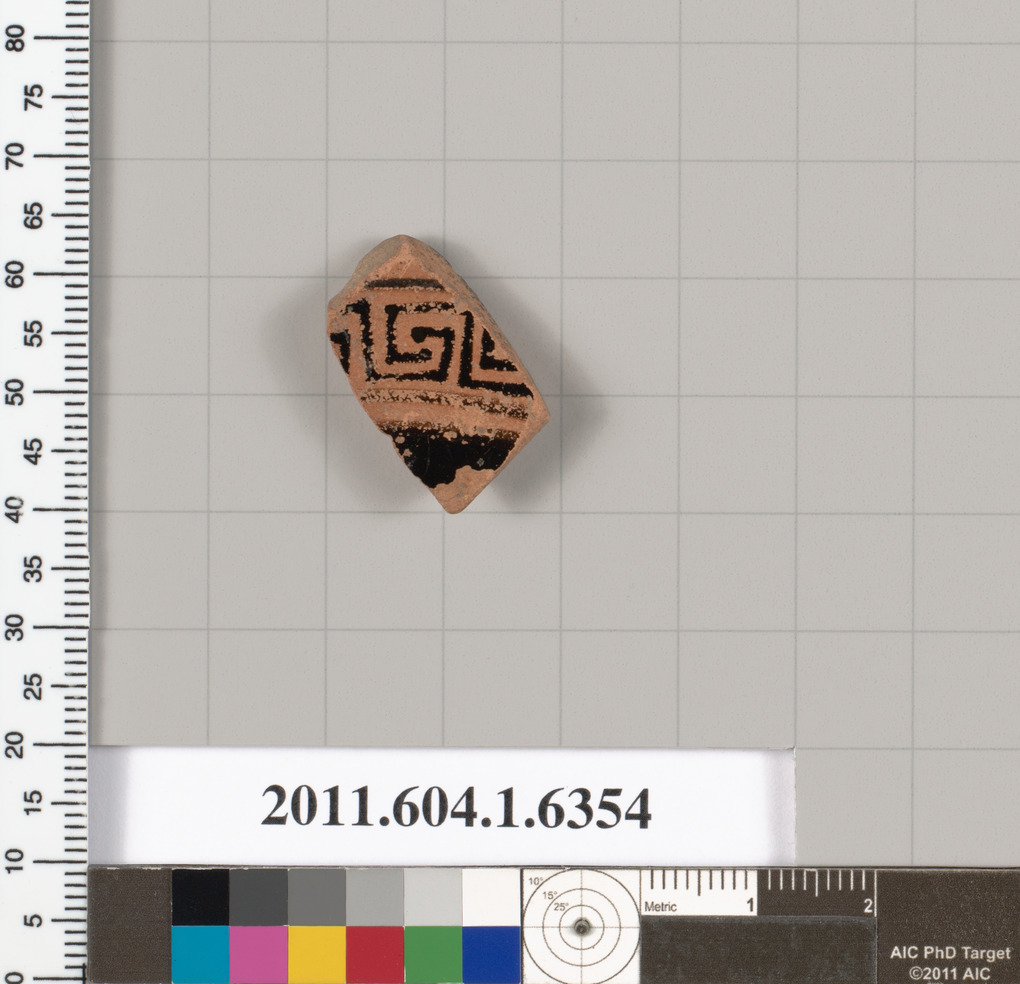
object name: kylix fragment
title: Terracotta fragment of a kylix (drinking cup)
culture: greek, attic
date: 500-480 BCE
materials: terracotta